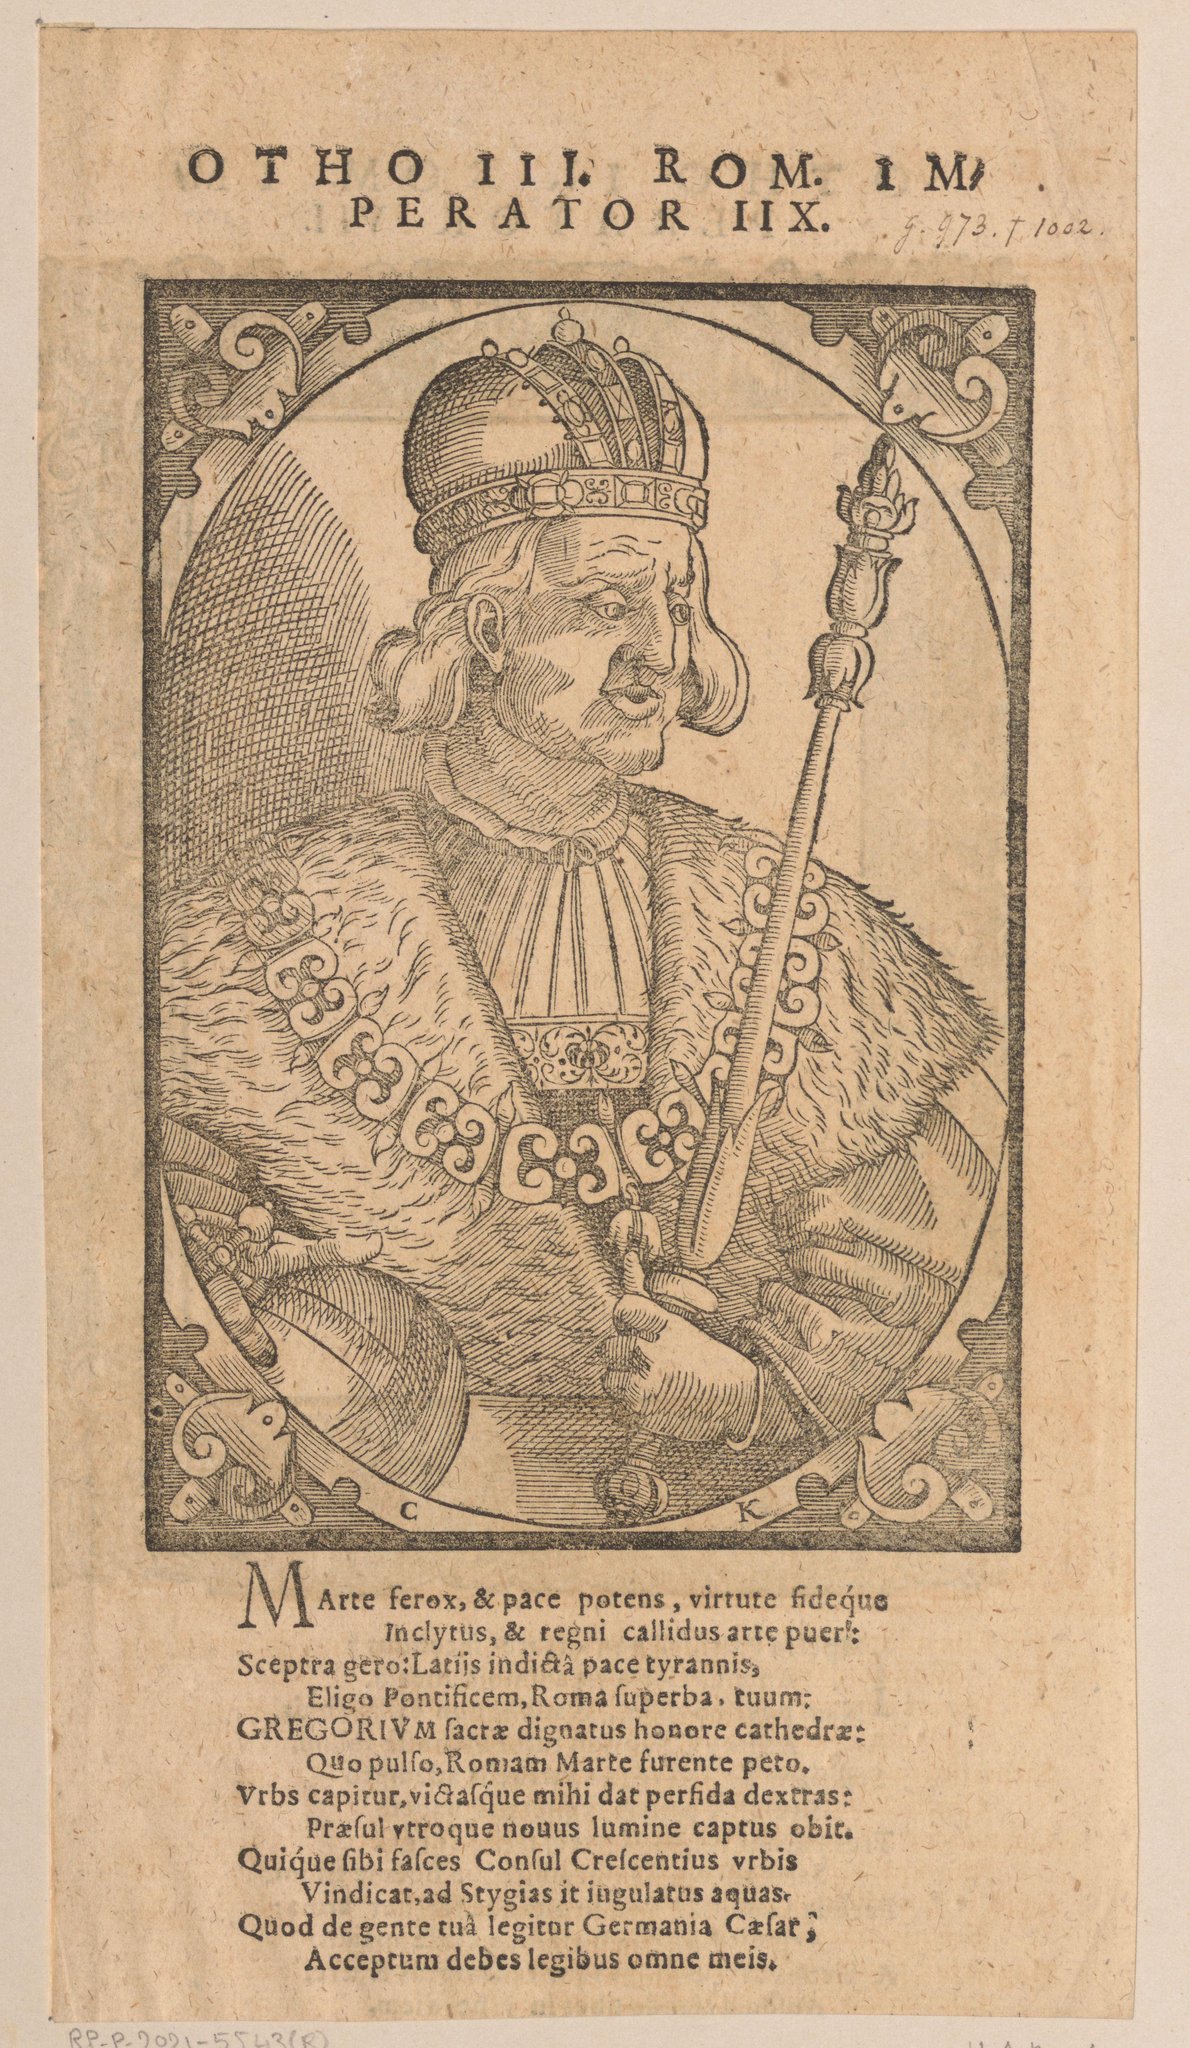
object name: print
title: Portret van Otto II, keizer van het Heilige Roomse Rijk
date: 1597-1610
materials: paper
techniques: letterpress printing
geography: leipzig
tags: historical persons, armorial bearing, heraldry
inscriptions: signature: ‘CK’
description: Prent uit: Reusner, Elias. Genealogiae regum electorum ducum (...). Leipzig: Henning Grosse I, 1610. Of een eerdere publicatie (1597).